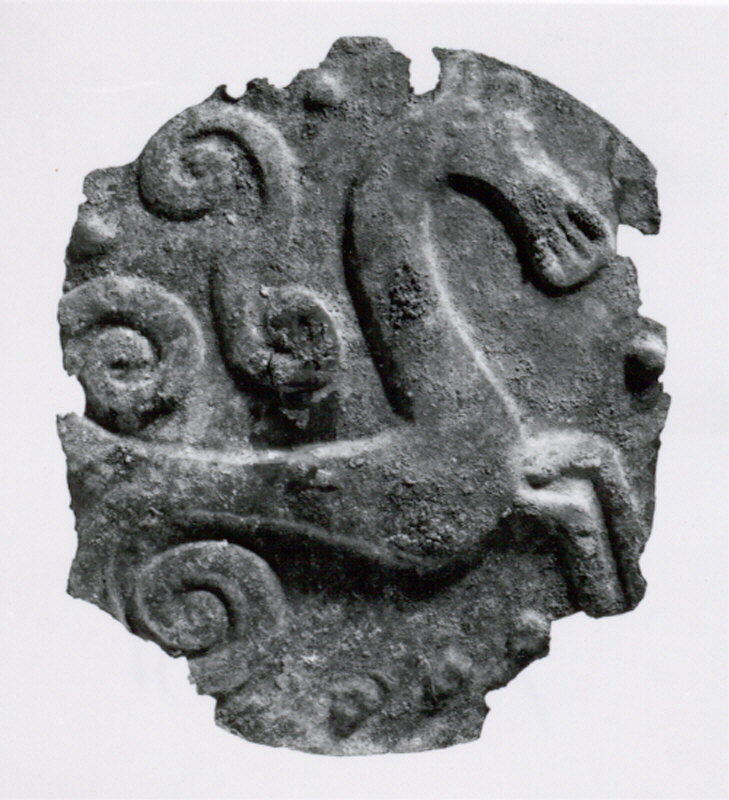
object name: roundel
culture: iranian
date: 1-1000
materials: bronze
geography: iran (?)